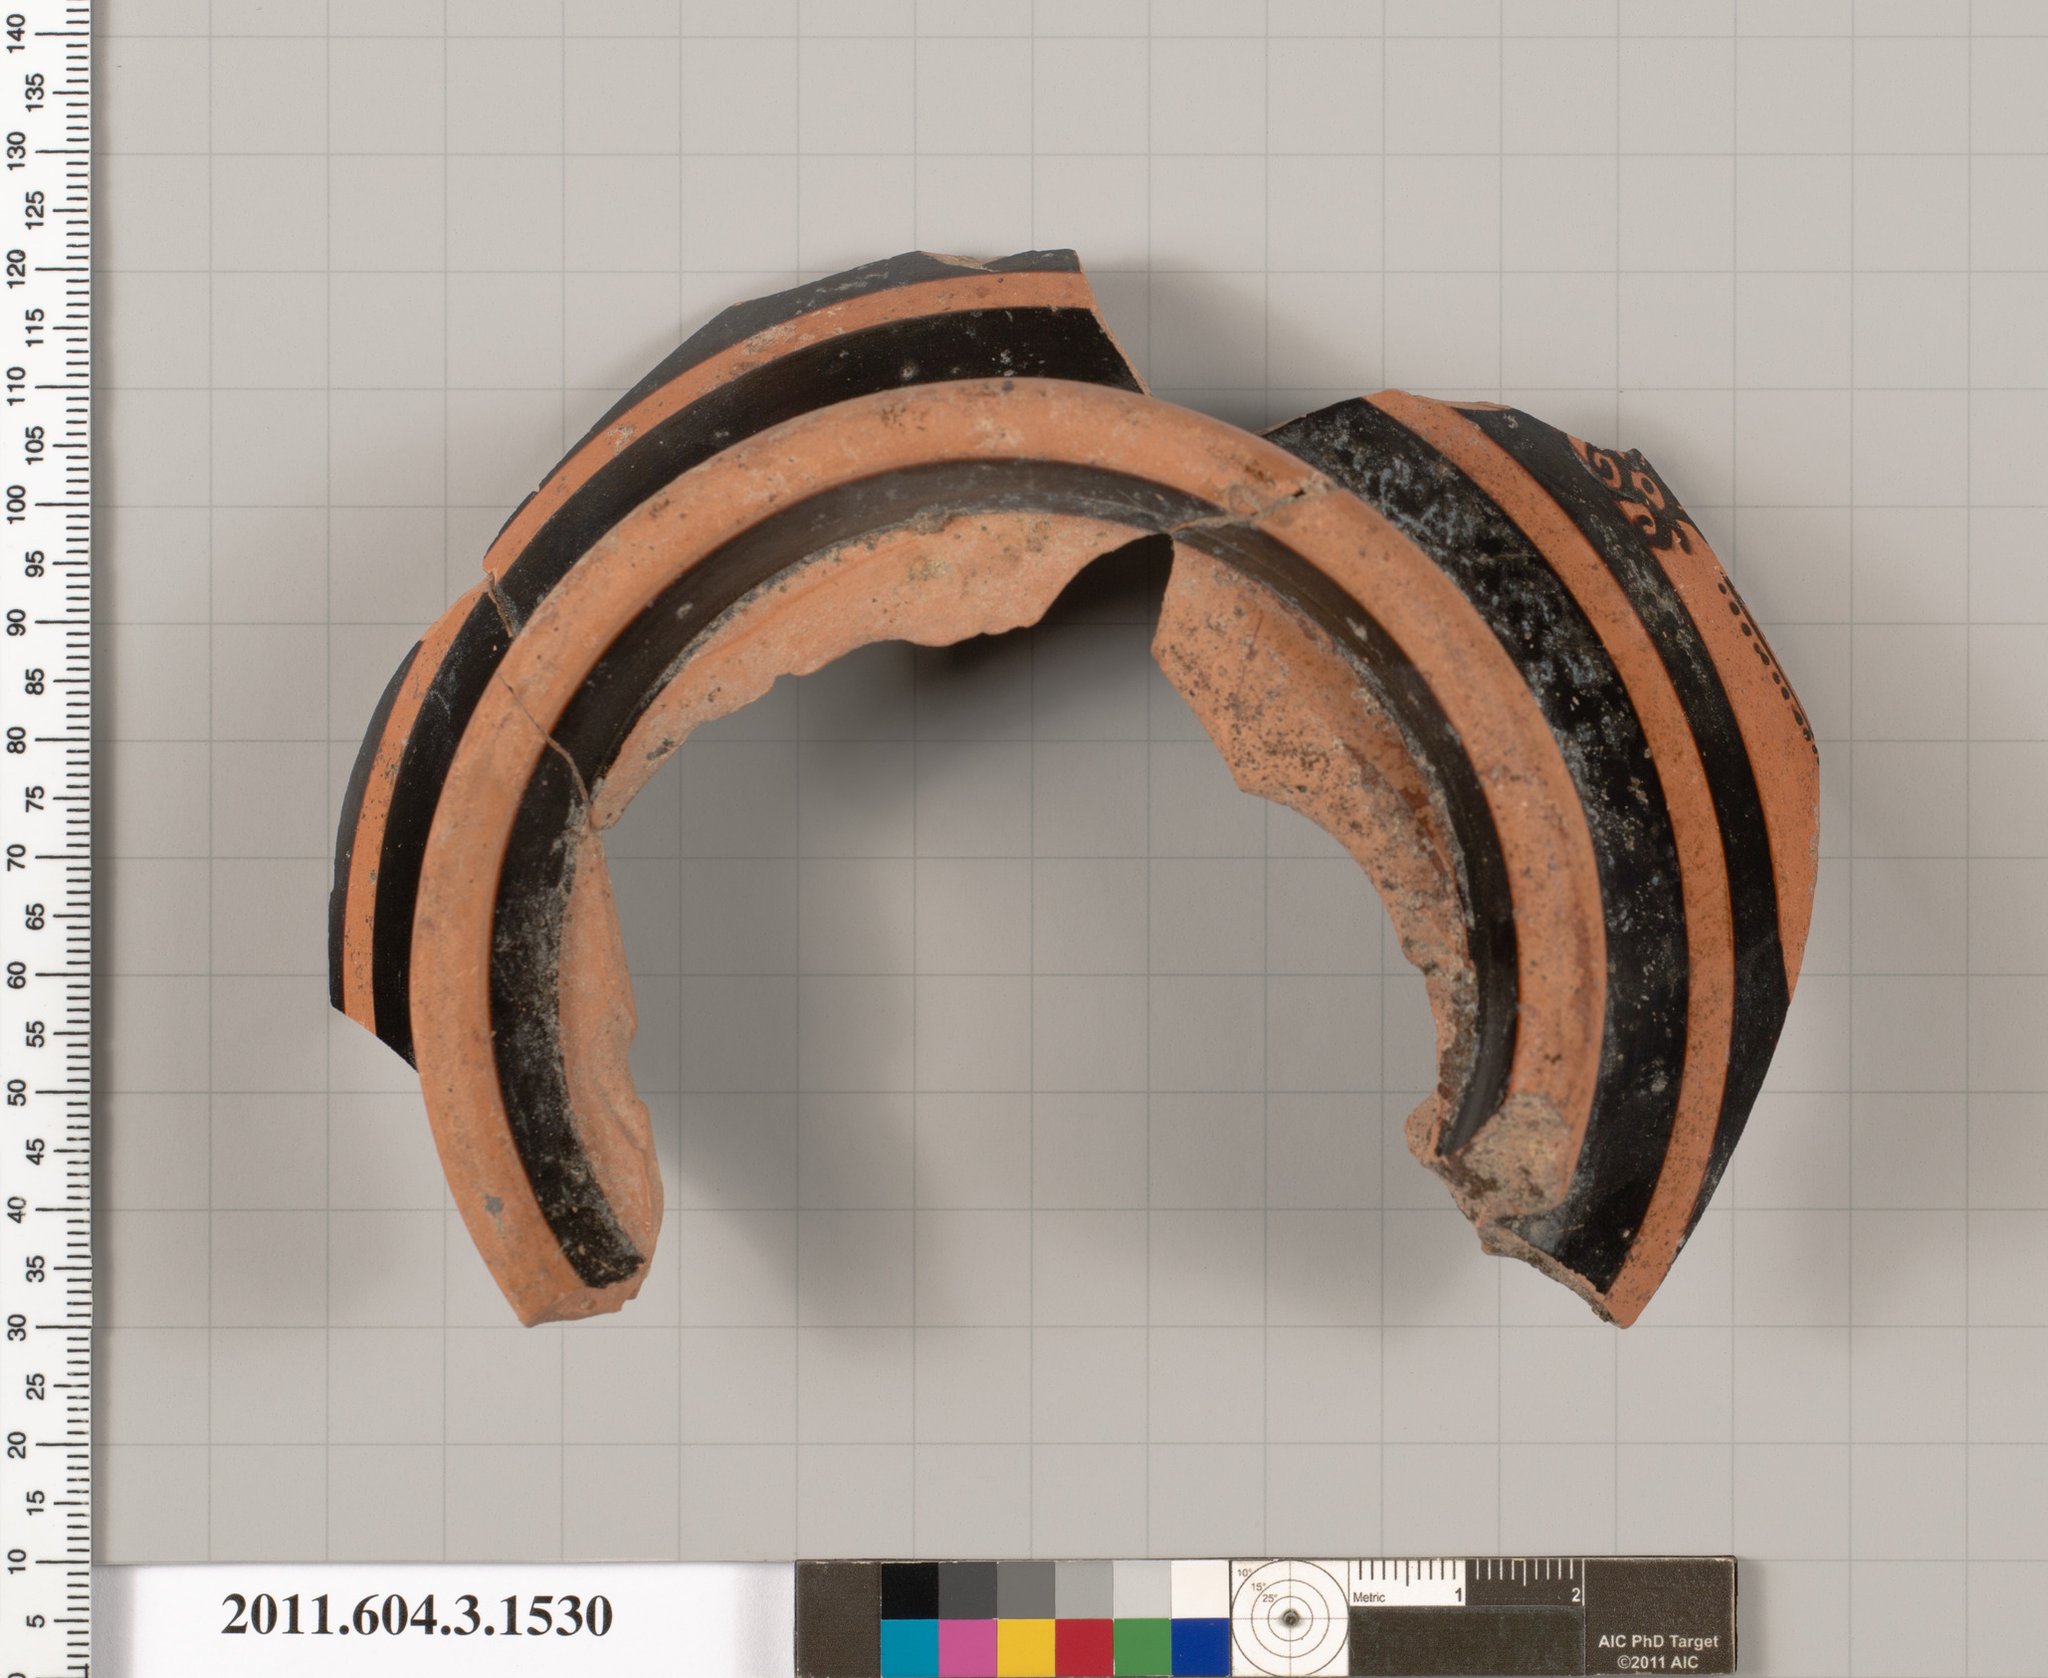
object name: skyphos fragment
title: Terracotta fragment of a skyphos (deep drinking cup)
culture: greek, attic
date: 534-468 BCE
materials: terracotta